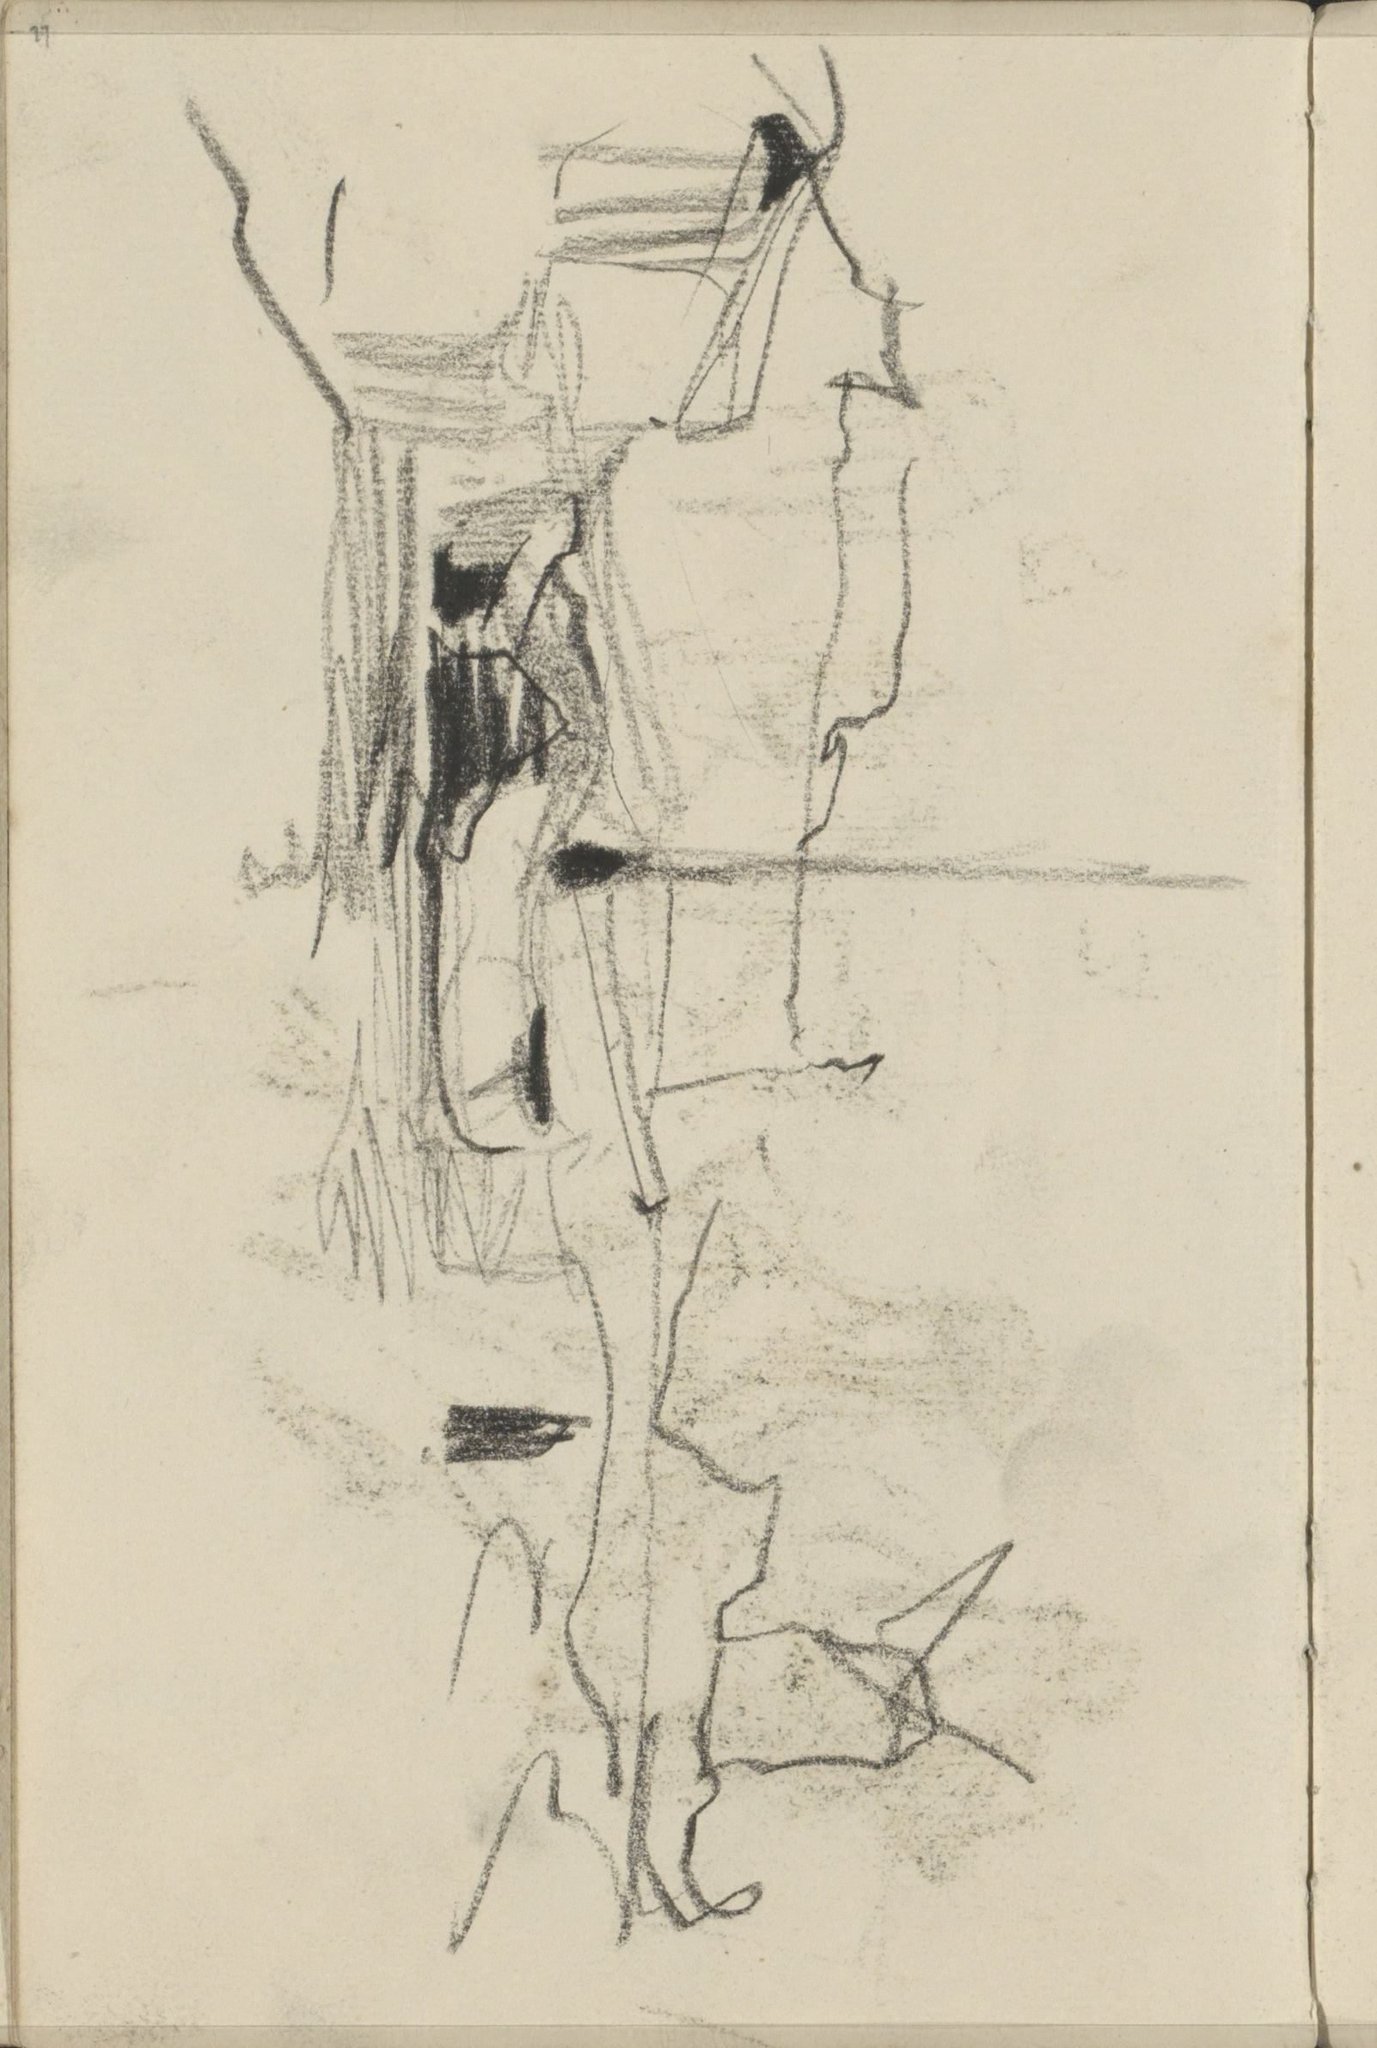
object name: sketchbook leaf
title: Boot in het water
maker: george hendrik breitner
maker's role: draughtsman, painter, print maker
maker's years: 1857-1923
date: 1886-1898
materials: chalk, paper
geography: amsterdam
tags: ships (in general), windmill in landscape, canals, waters (in city)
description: Op de achtergrond een molen, mogelijk De Victor. Pagina 27 uit een schetsboek met 18 bladen.